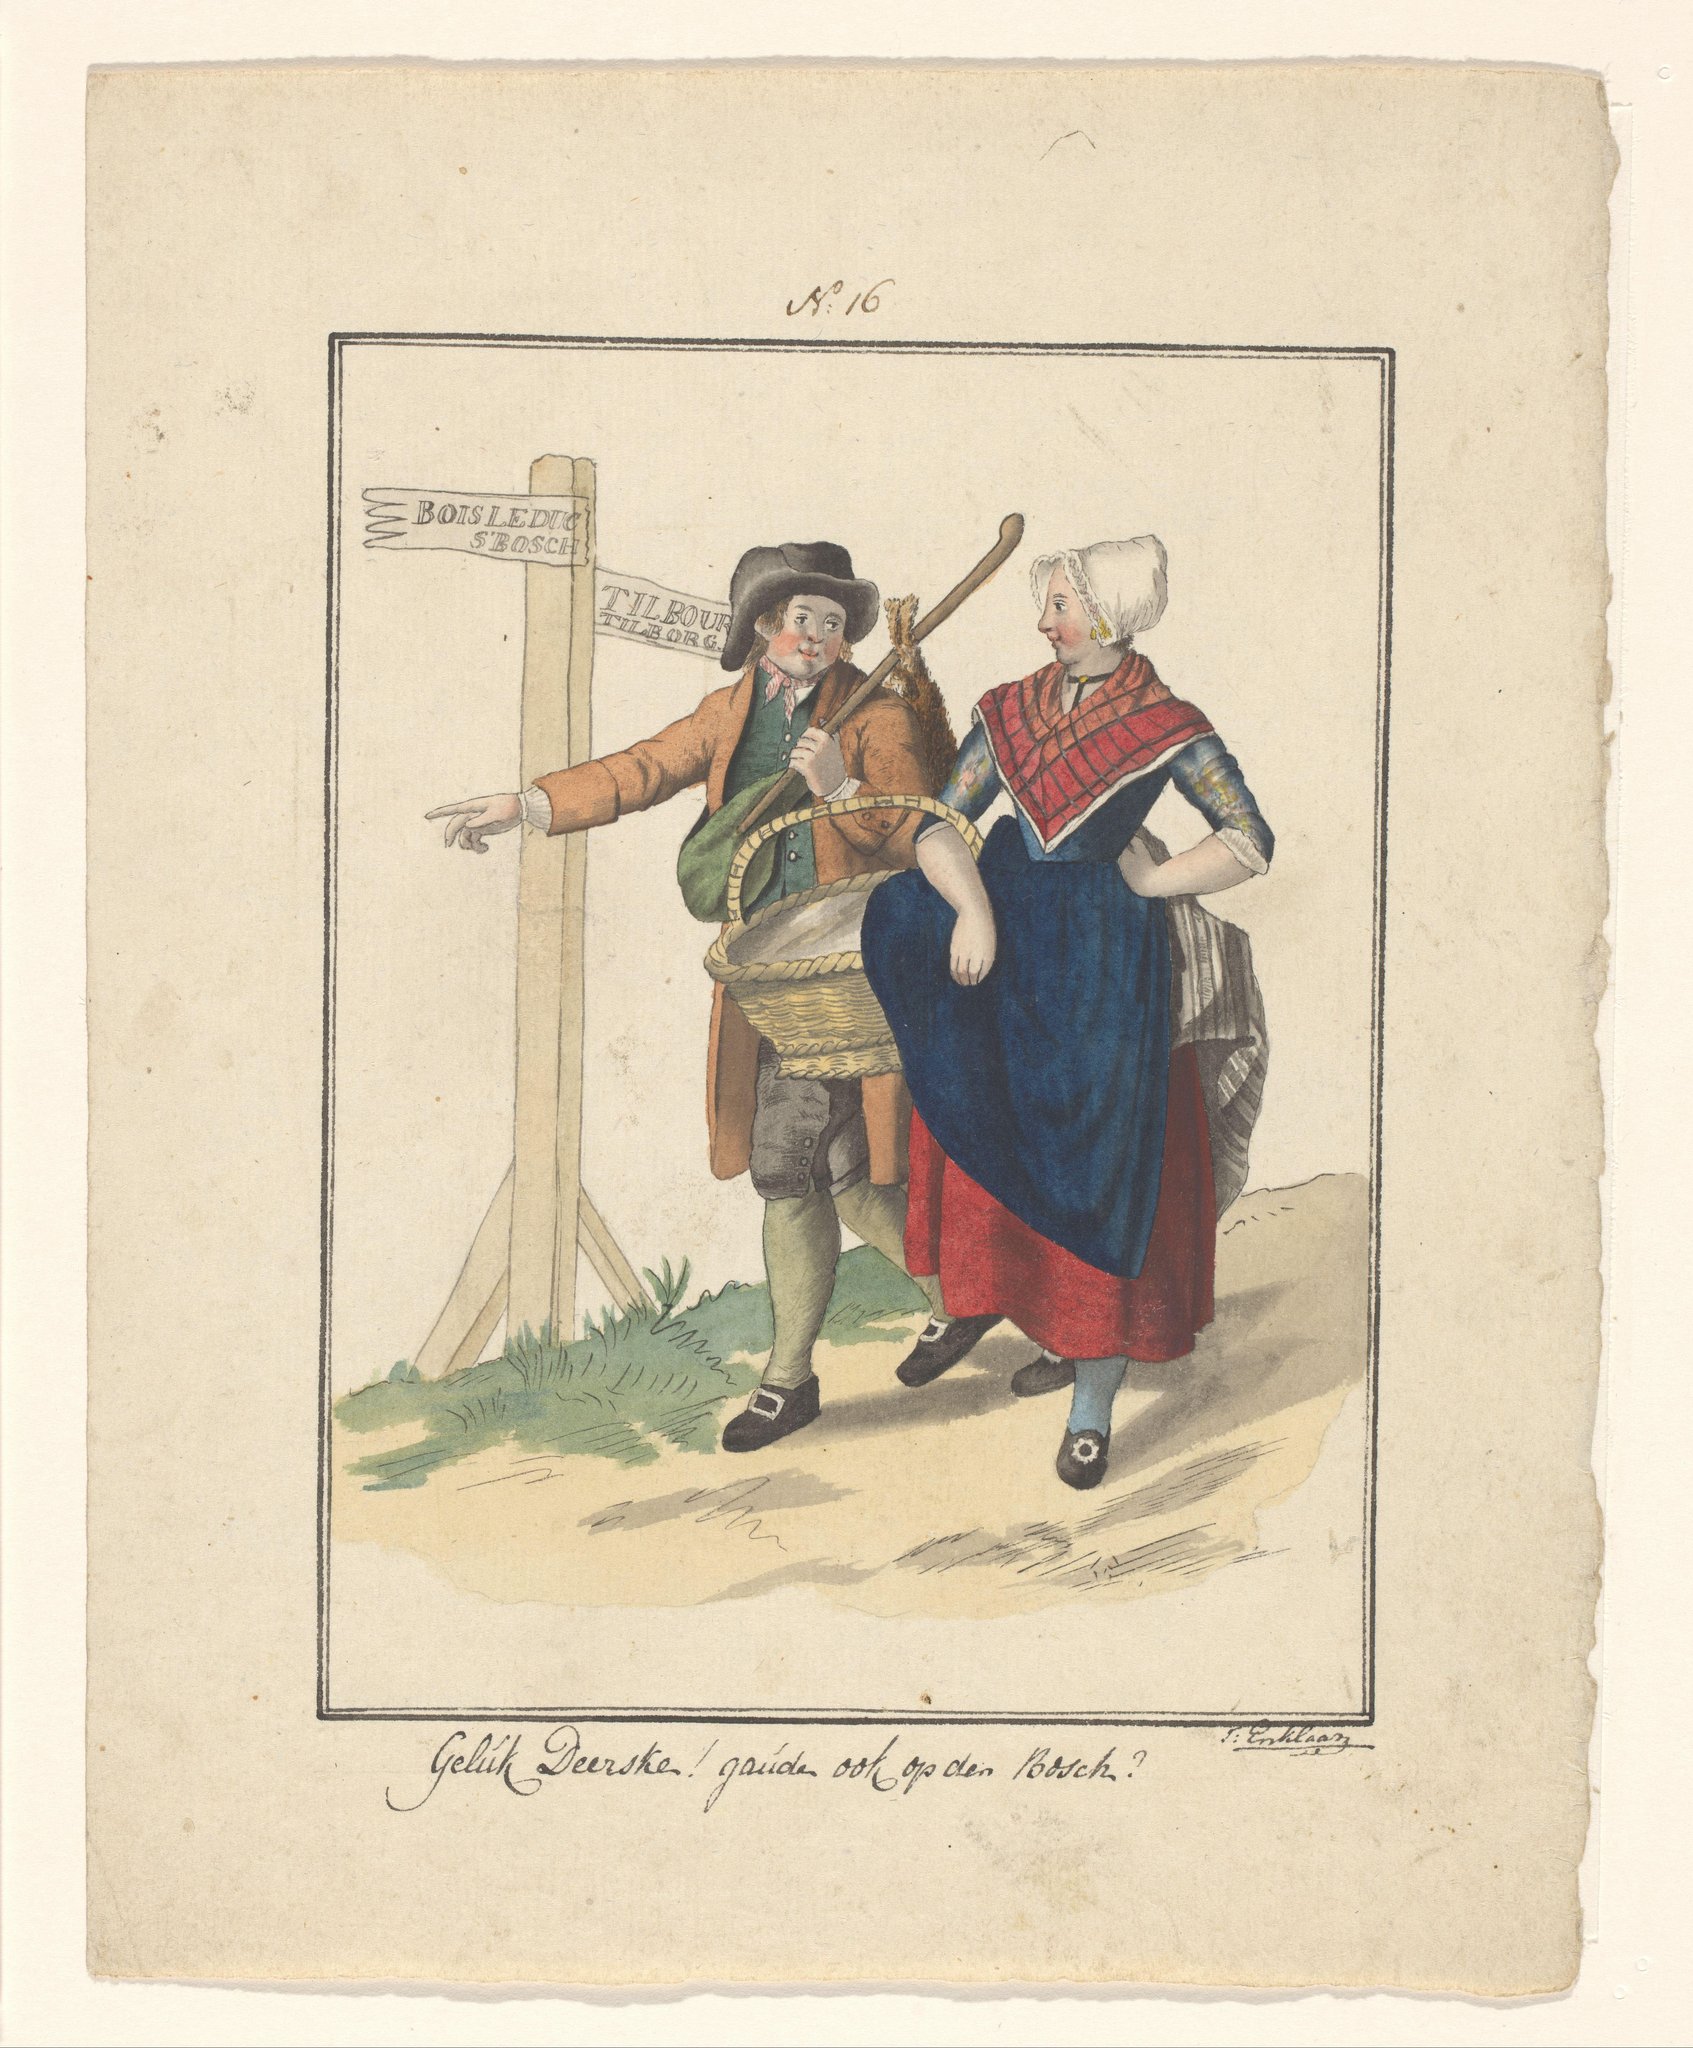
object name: drawing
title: Boer en boerin uit Cromhout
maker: j. enklaar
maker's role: draughtsman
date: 1803-1899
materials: ink, paper, watercolor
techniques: brush, pen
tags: rodents: hare, carrying something in basket, bag, rucksack, etc., folk costume, regional costume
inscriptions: number: ‘No:16’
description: Getekend naar prenten uit: Maaskamp, Evert. Afbeeldingen van de kleeding, zeden en gewoonten in de Bataafsche Republiek, met den aanvang der negentiende eeuw. Amsterdam: Evert Maaskamp, [1803-1807].